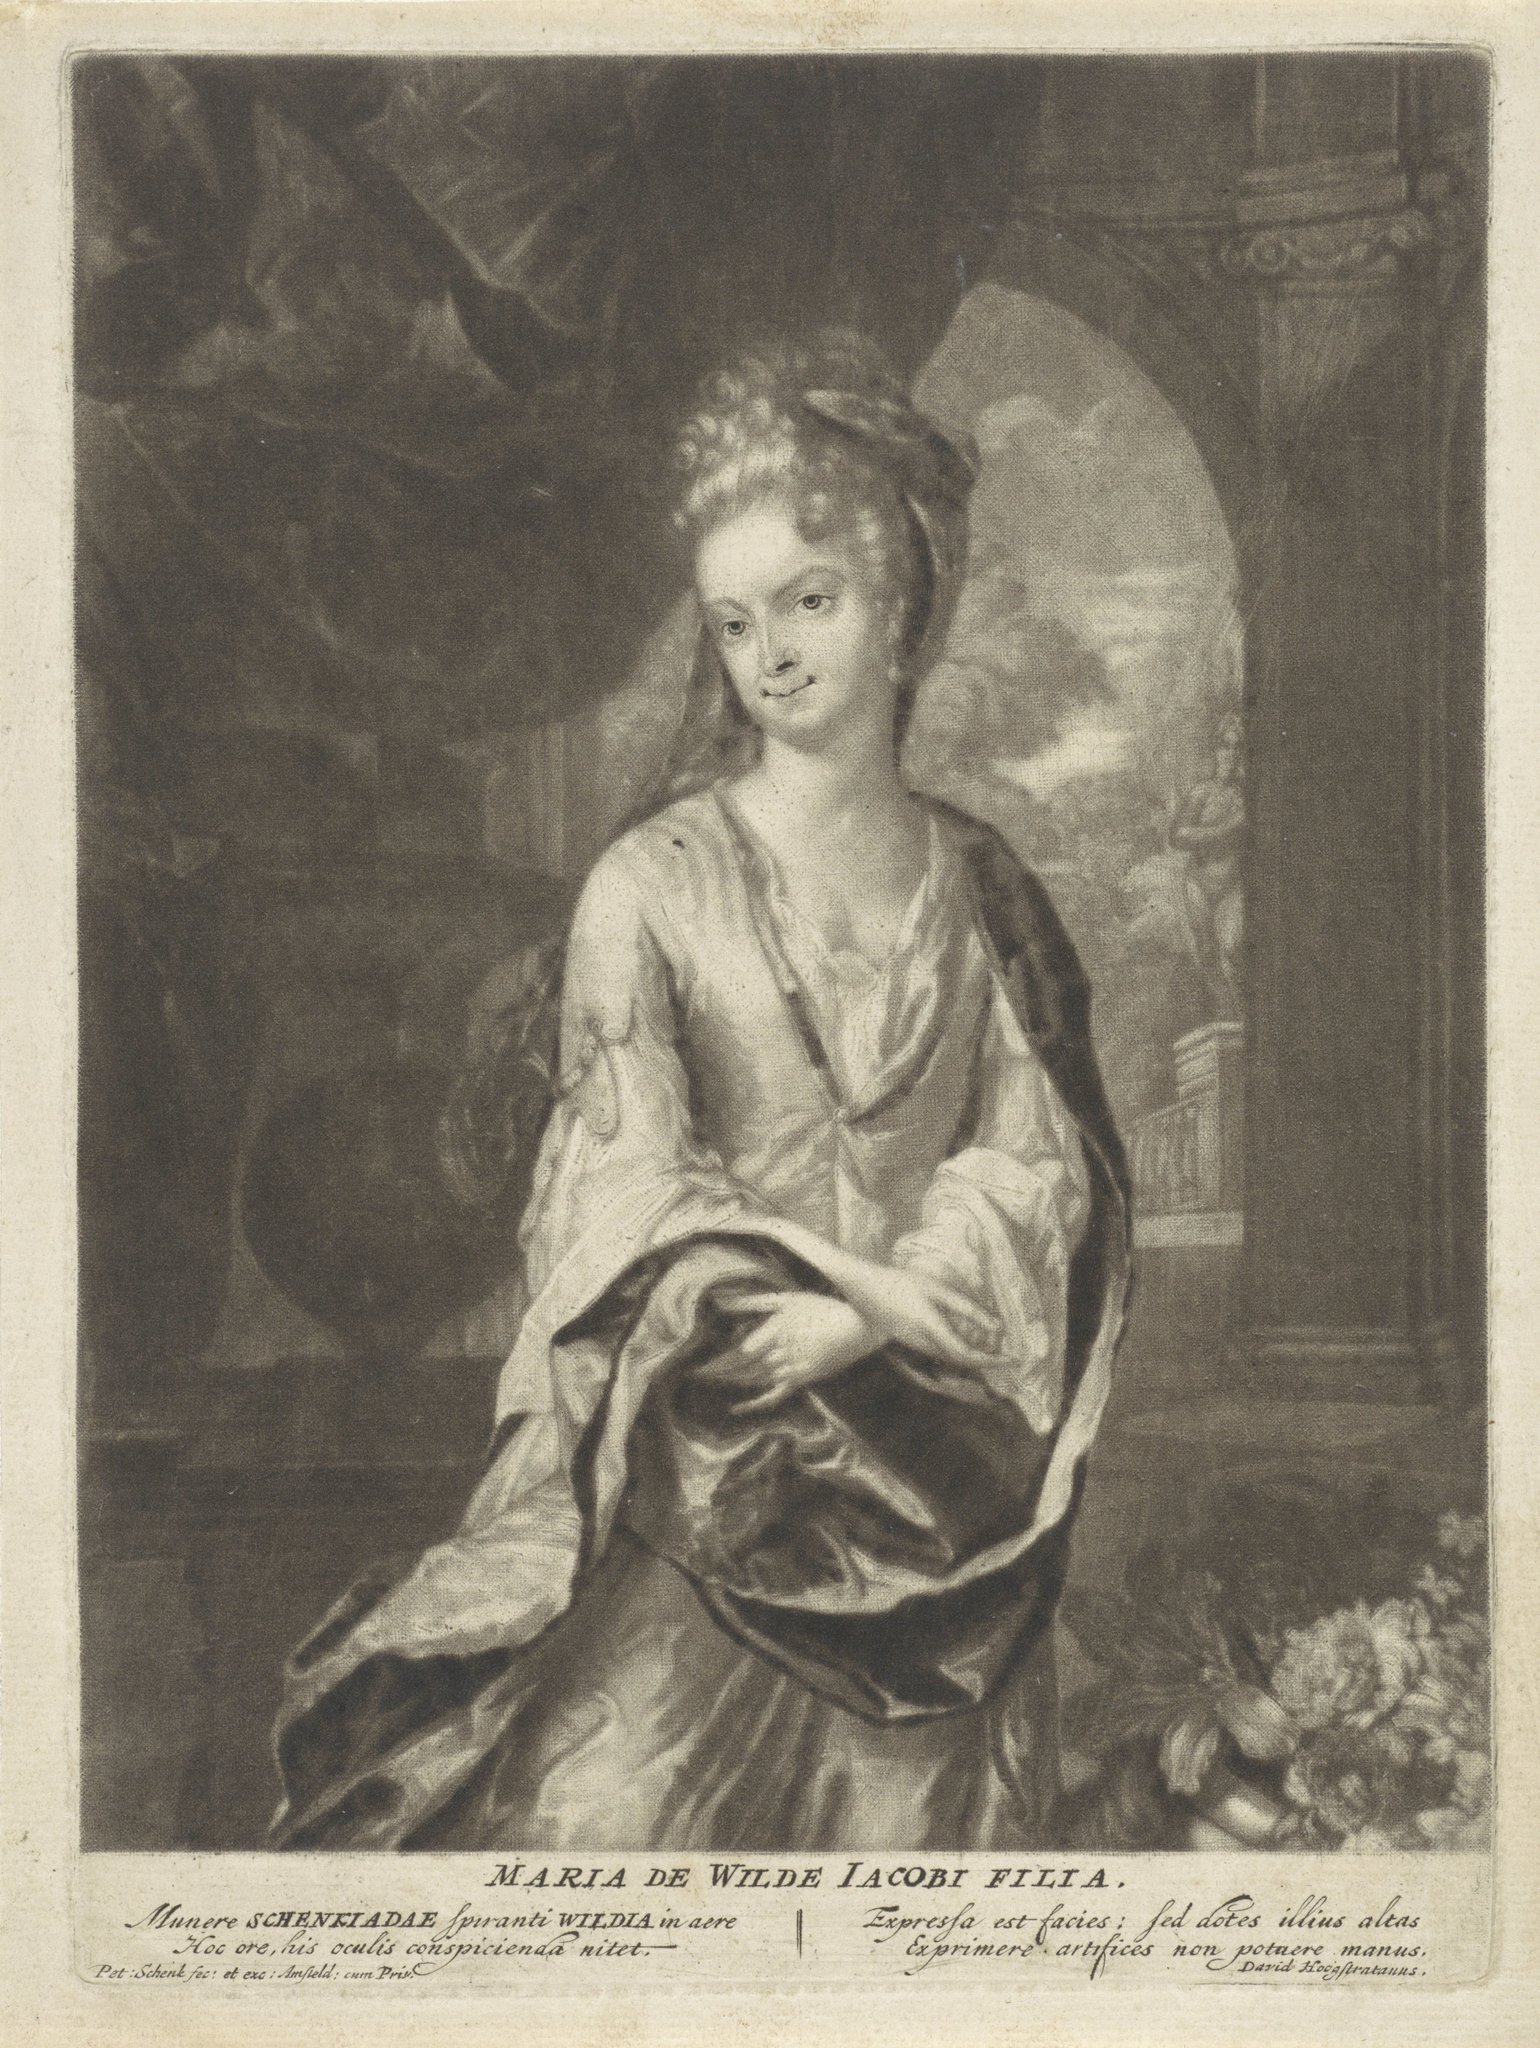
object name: print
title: Portret van Maria de Wilde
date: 1702-1713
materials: paper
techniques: engraving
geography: amsterdam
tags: print maker, maria de wilde, cut flowers; nosegay, bunch of flowers, portrait, self-portrait of artist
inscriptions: collector's mark: Lugt 2228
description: De schilderes en dichteres Maria de Wilde. Op de achtergrond een terras.